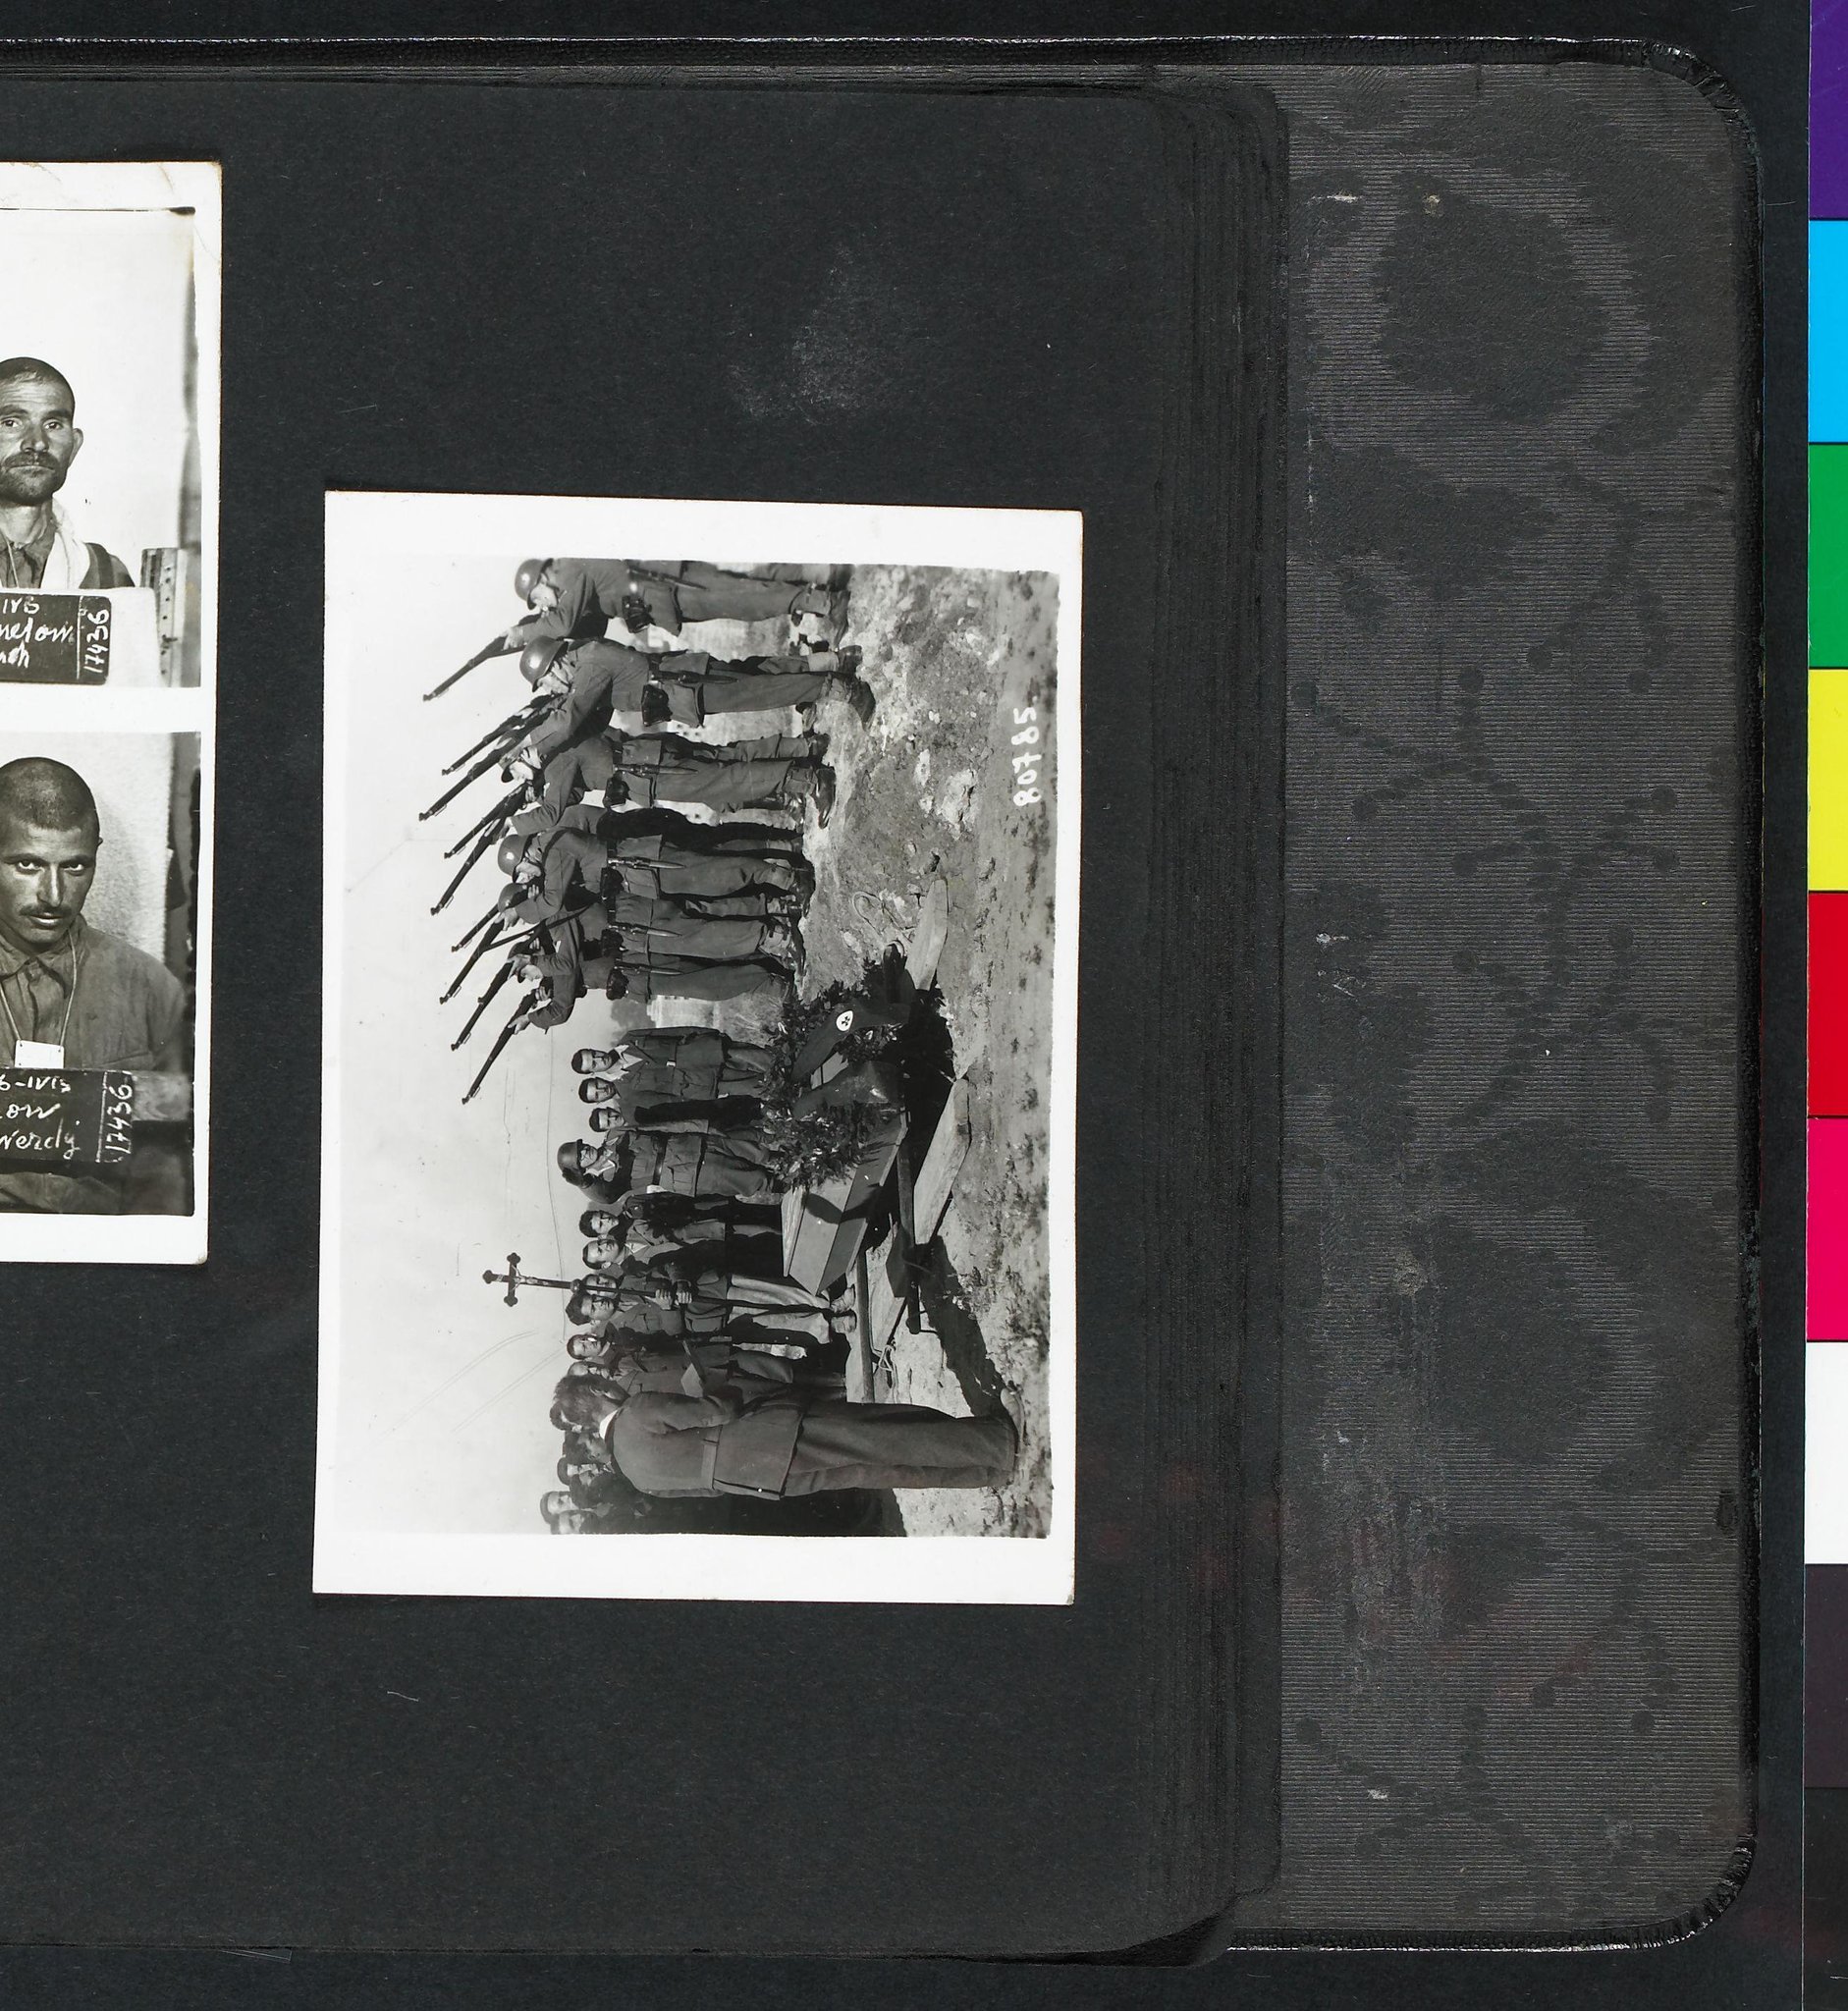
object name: photograph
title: Russische krijgsgevangen en andere foto's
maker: dick w.b. van maarseveen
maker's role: fotograaf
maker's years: 1905-1990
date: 1943-1945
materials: cardboard, photographic support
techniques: gelatin silver print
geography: muhlberg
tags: the hague, dick w.b. van maarseveen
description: Albumblad met drie foto's: acht Russische krijgsgevangenen met bord waarop naam en nummer, een oude foto van de ingang van het kamp tijdens de bouw en een begrafenis van een gevangene. Onderdeel van een fotoalbum met foto's door Dick van Maarseveen van het krijgsgevangenenkamp Stalag IV B in Mühlberg in de periode 1943-1945.